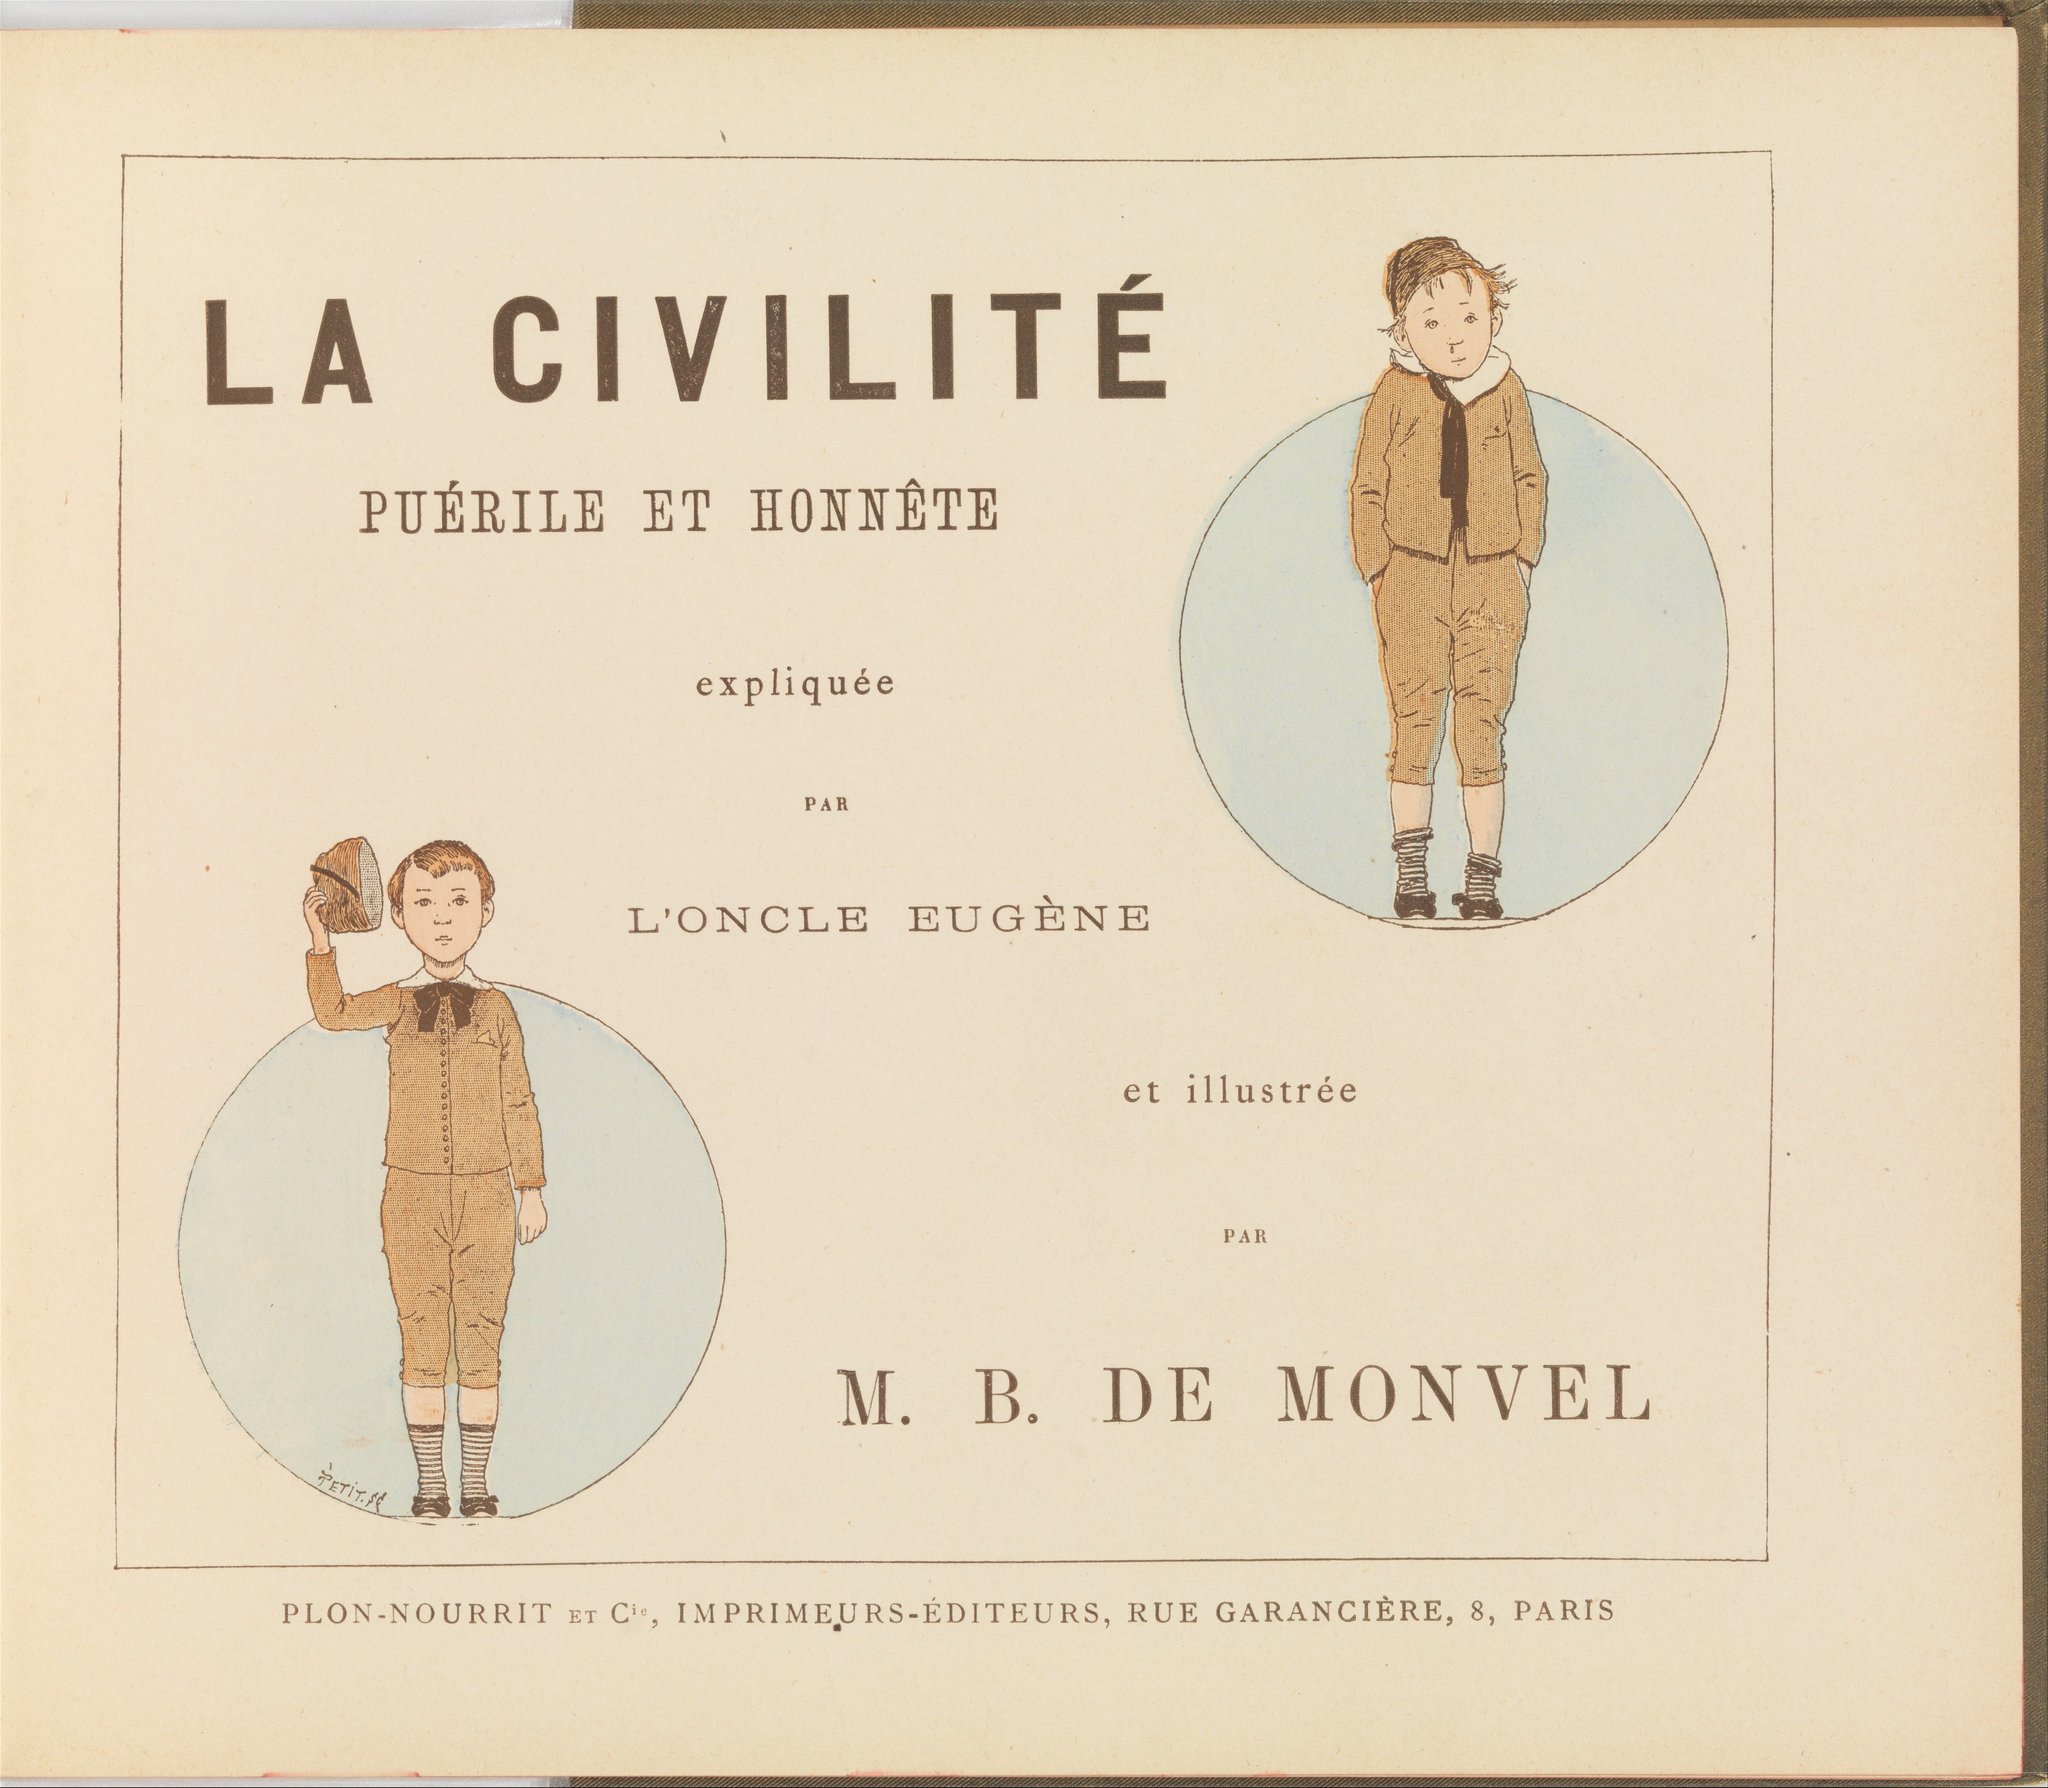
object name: book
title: La Civilité Puérile et Honnête expliquée par l'Oncle Eugène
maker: eugène plon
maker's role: author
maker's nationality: french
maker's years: 1836-1895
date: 1887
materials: wood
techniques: engraving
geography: france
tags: boys